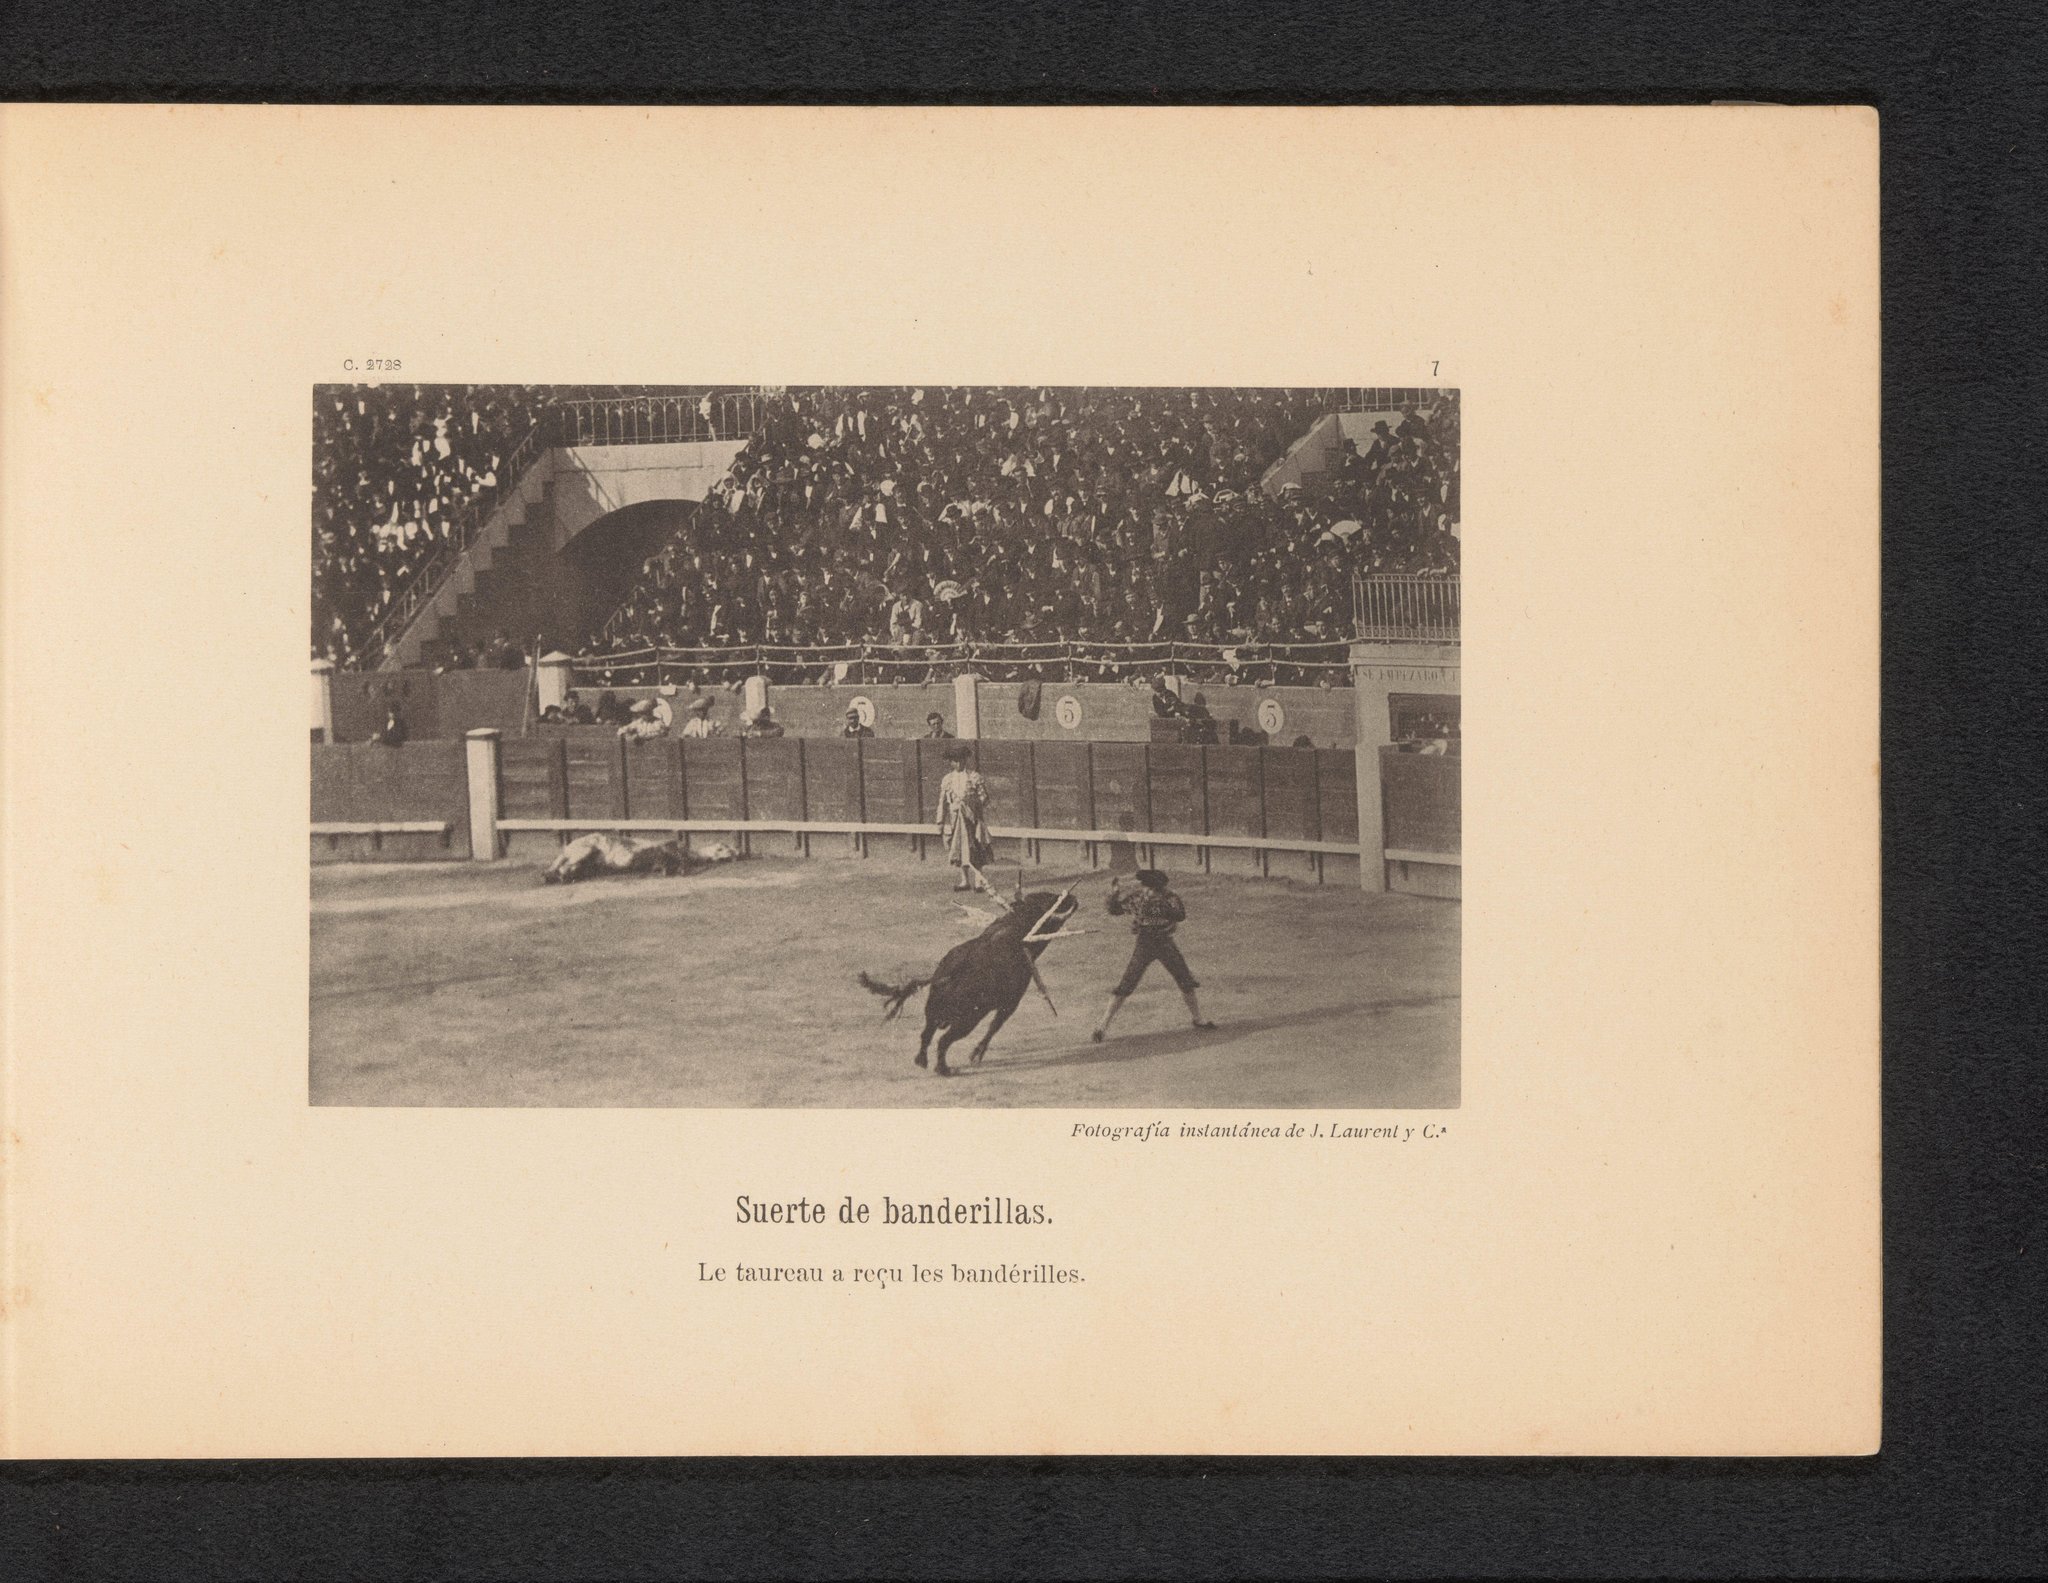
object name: page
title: Banderillero valt een stier aan in de stierenvechtersarena van Carretera de Aragon te Madrid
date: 1880-1890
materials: paper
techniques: photograph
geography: madrid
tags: bullfight, bull-fighter, toreador, theatre (building) - aa - open-air performances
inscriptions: number: ‘7’, number: ‘C. 2728’